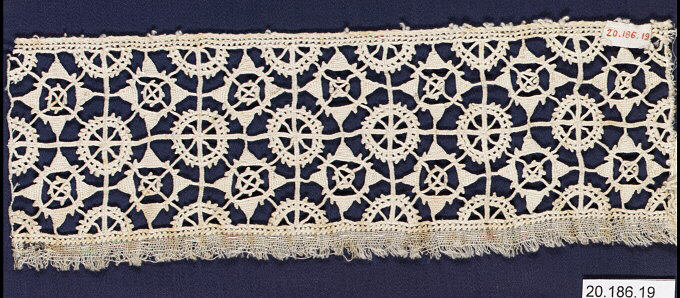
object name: strip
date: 1501-1600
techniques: lace